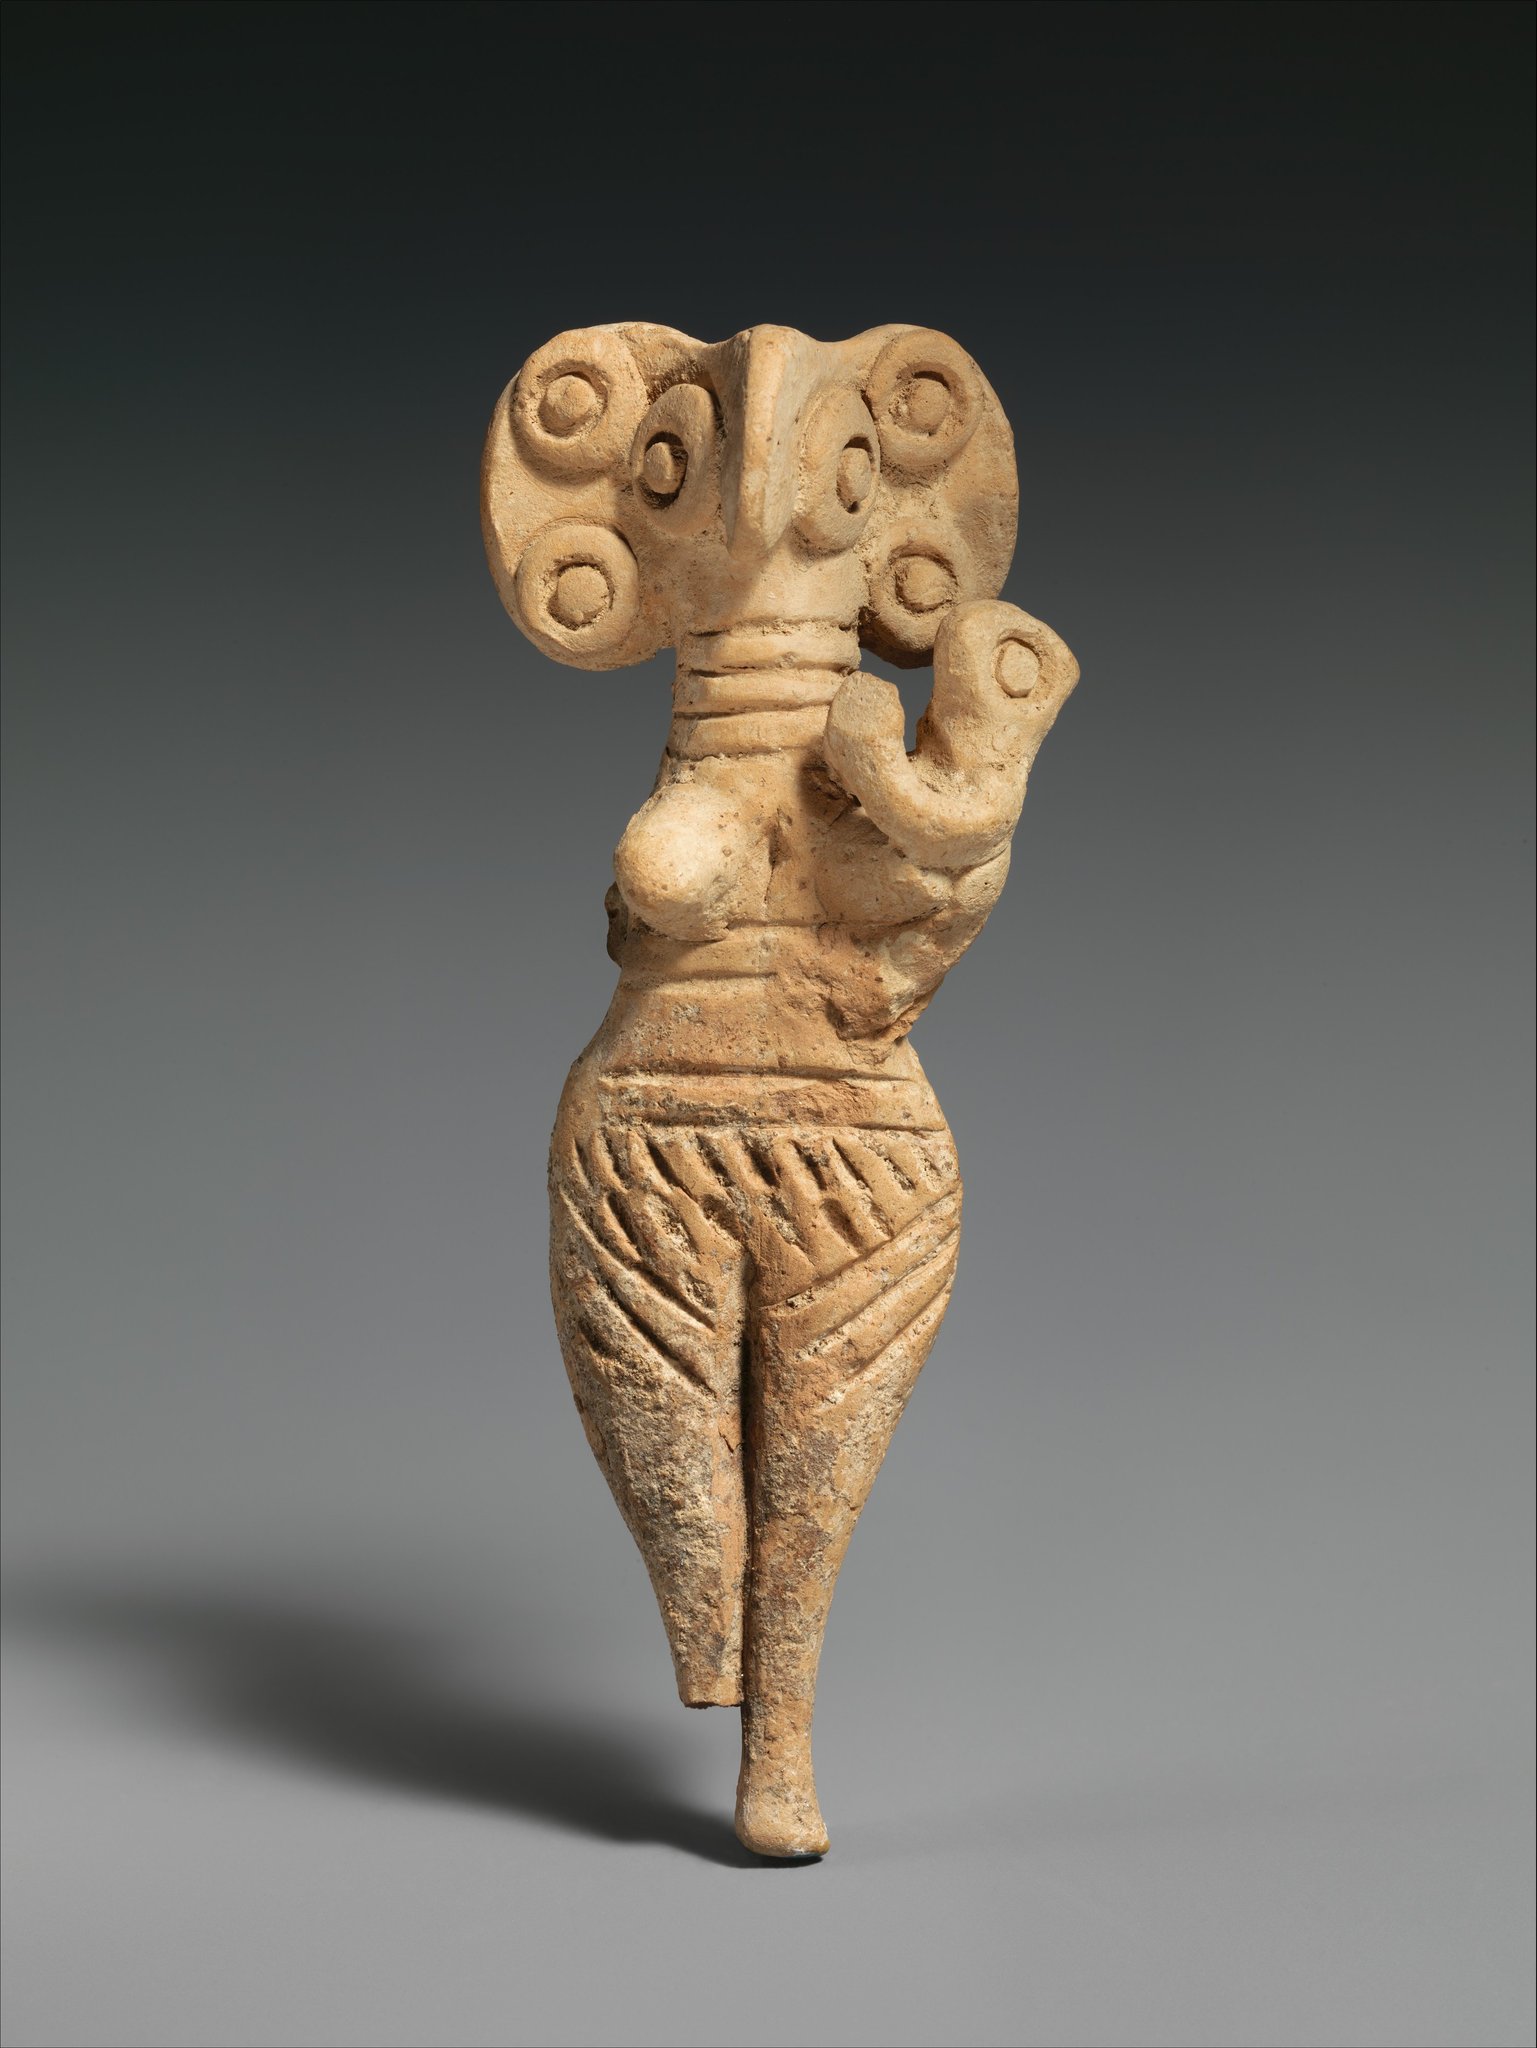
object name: statuette of a woman with bird face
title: Terracotta statuette of woman with bird face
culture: cypriot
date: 1450-1200 BCE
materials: terracotta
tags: birds,women